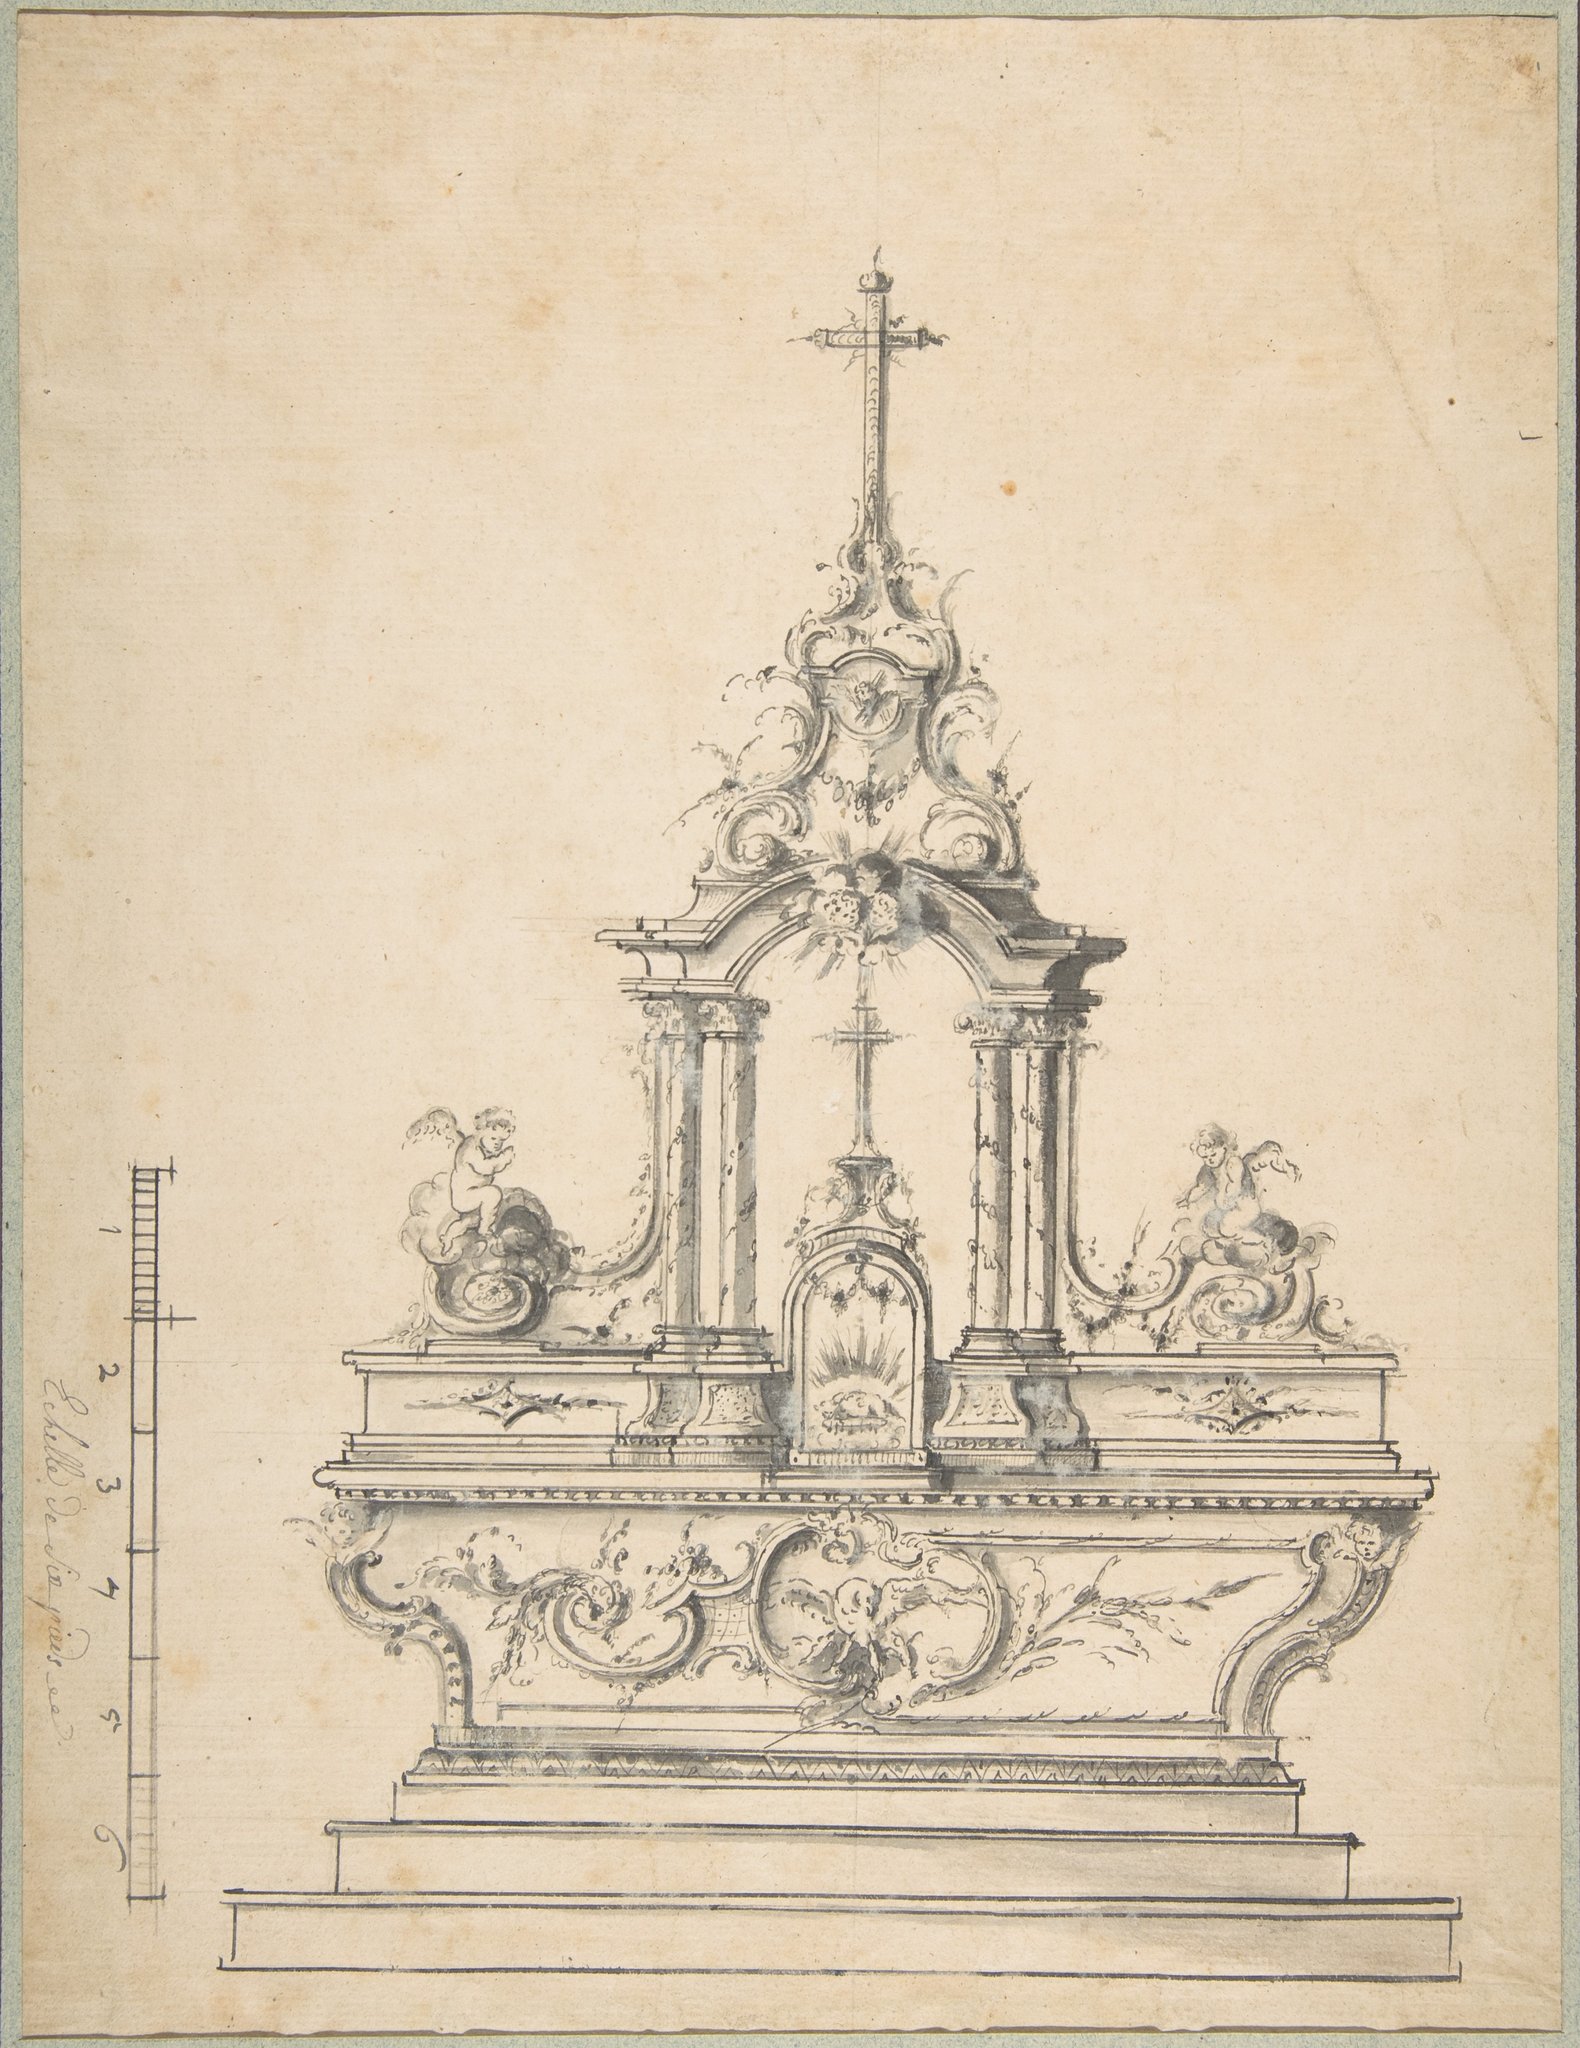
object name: drawing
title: Design for an Altar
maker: anonymous, french, 18th century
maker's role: artist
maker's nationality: french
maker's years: 1700-1800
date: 1701-1800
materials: ink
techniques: brush, pen, wash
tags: altars,angels,cross